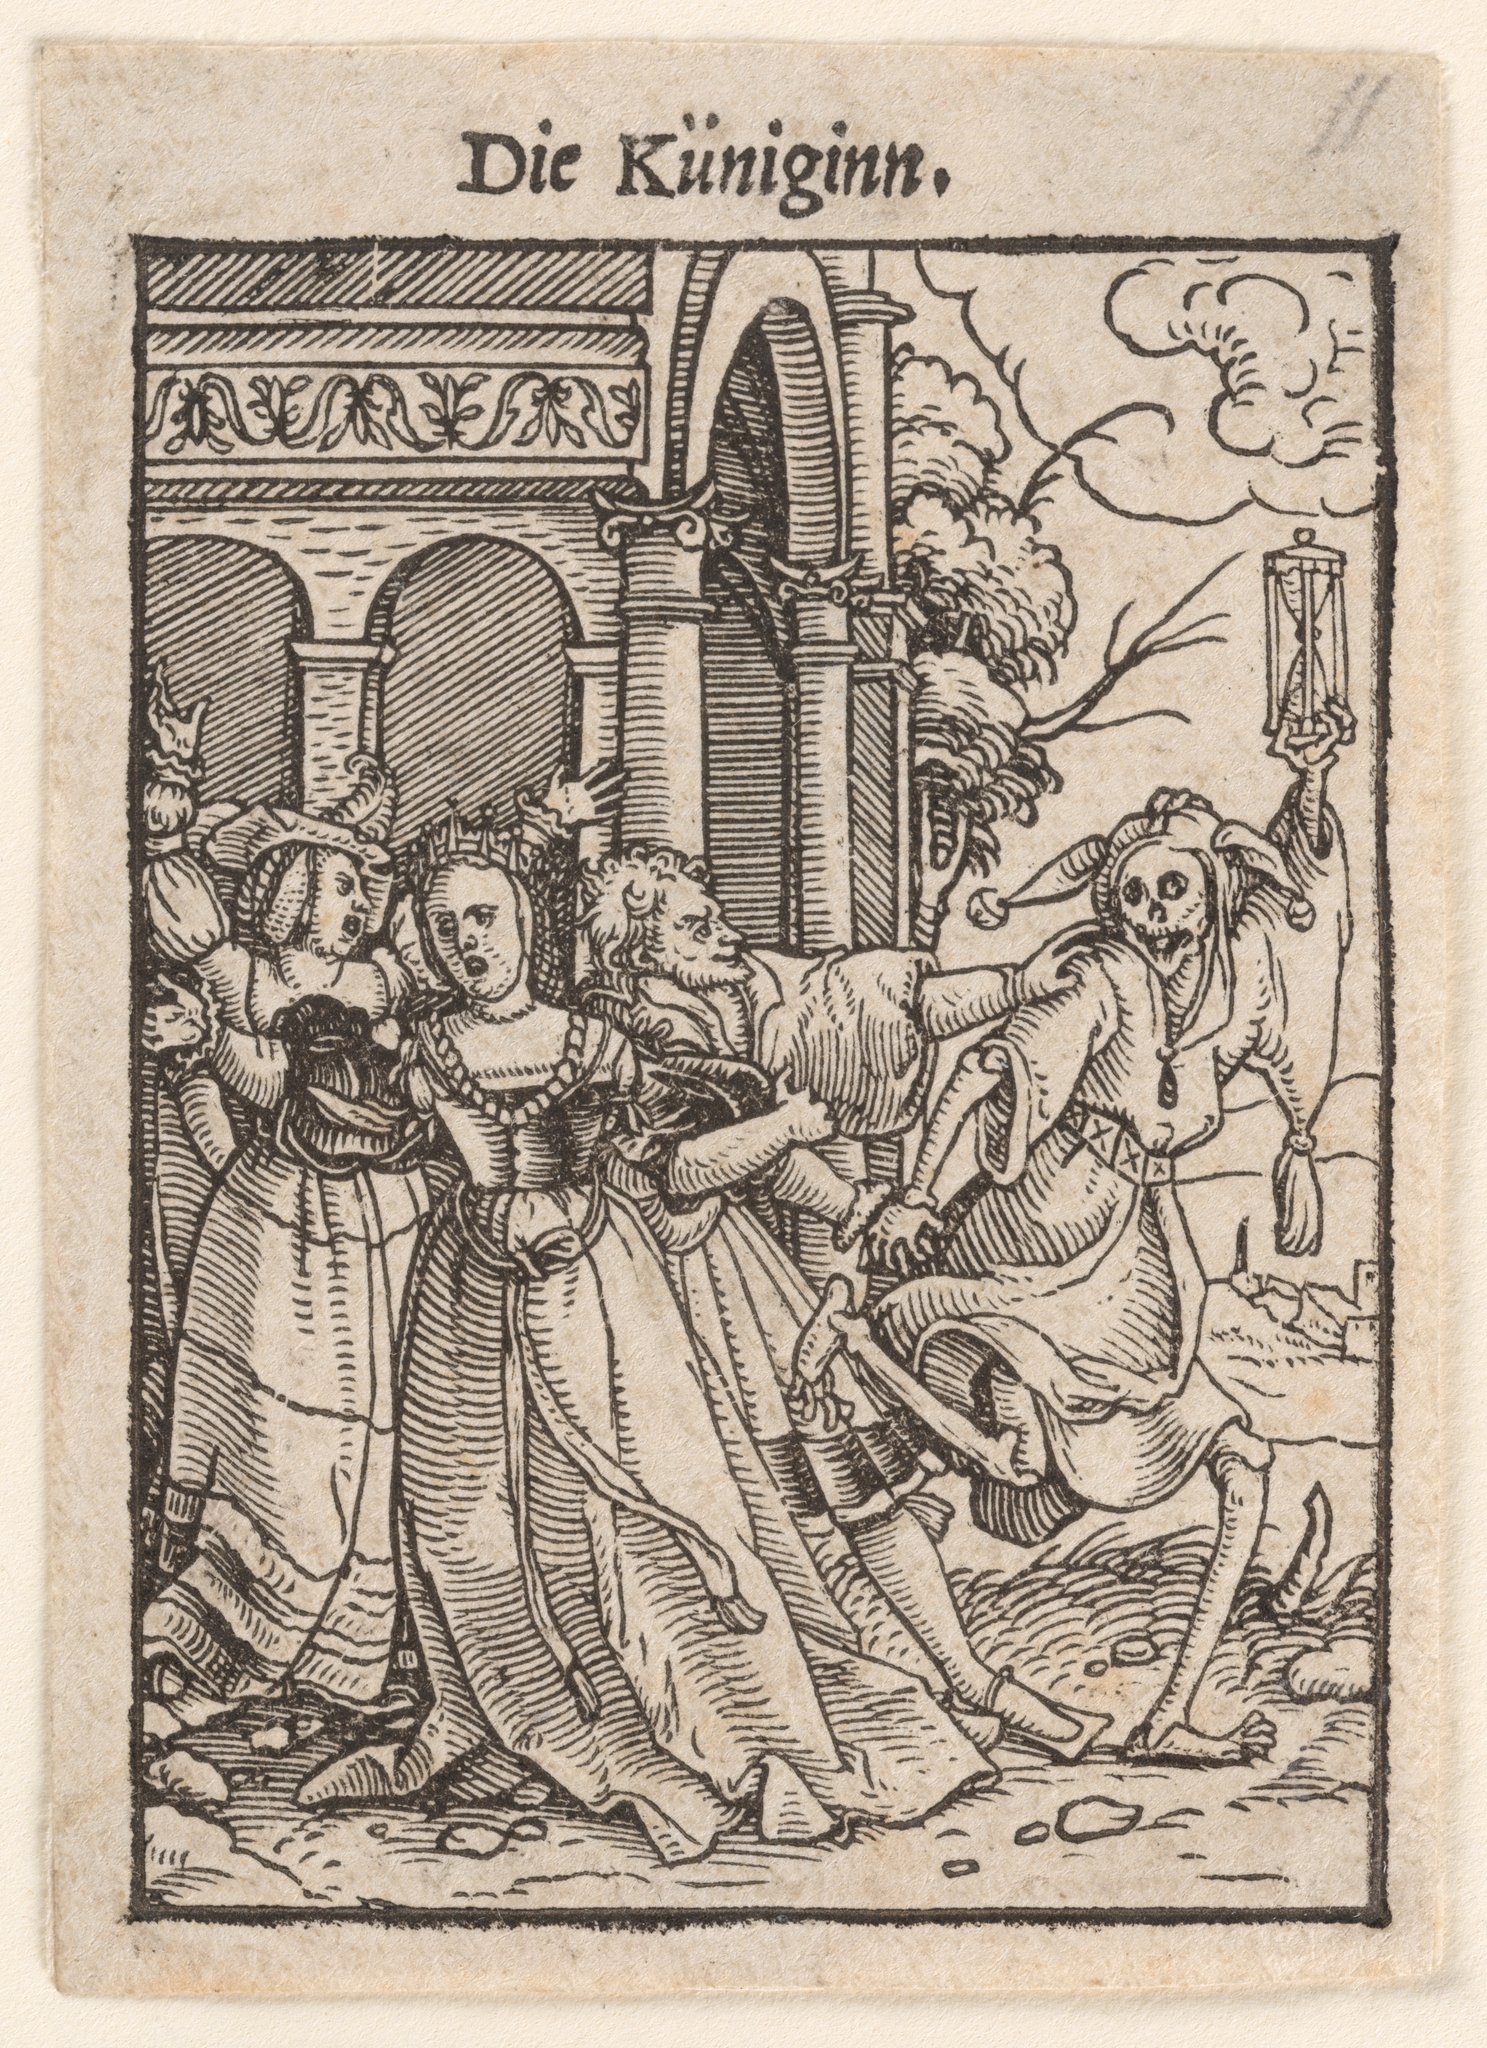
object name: print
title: The Queen, from "The Dance of Death"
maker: hans holbein the younger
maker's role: artist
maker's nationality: german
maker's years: 1497-1543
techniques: woodcut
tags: queens,skeletons,women,death,hourglass